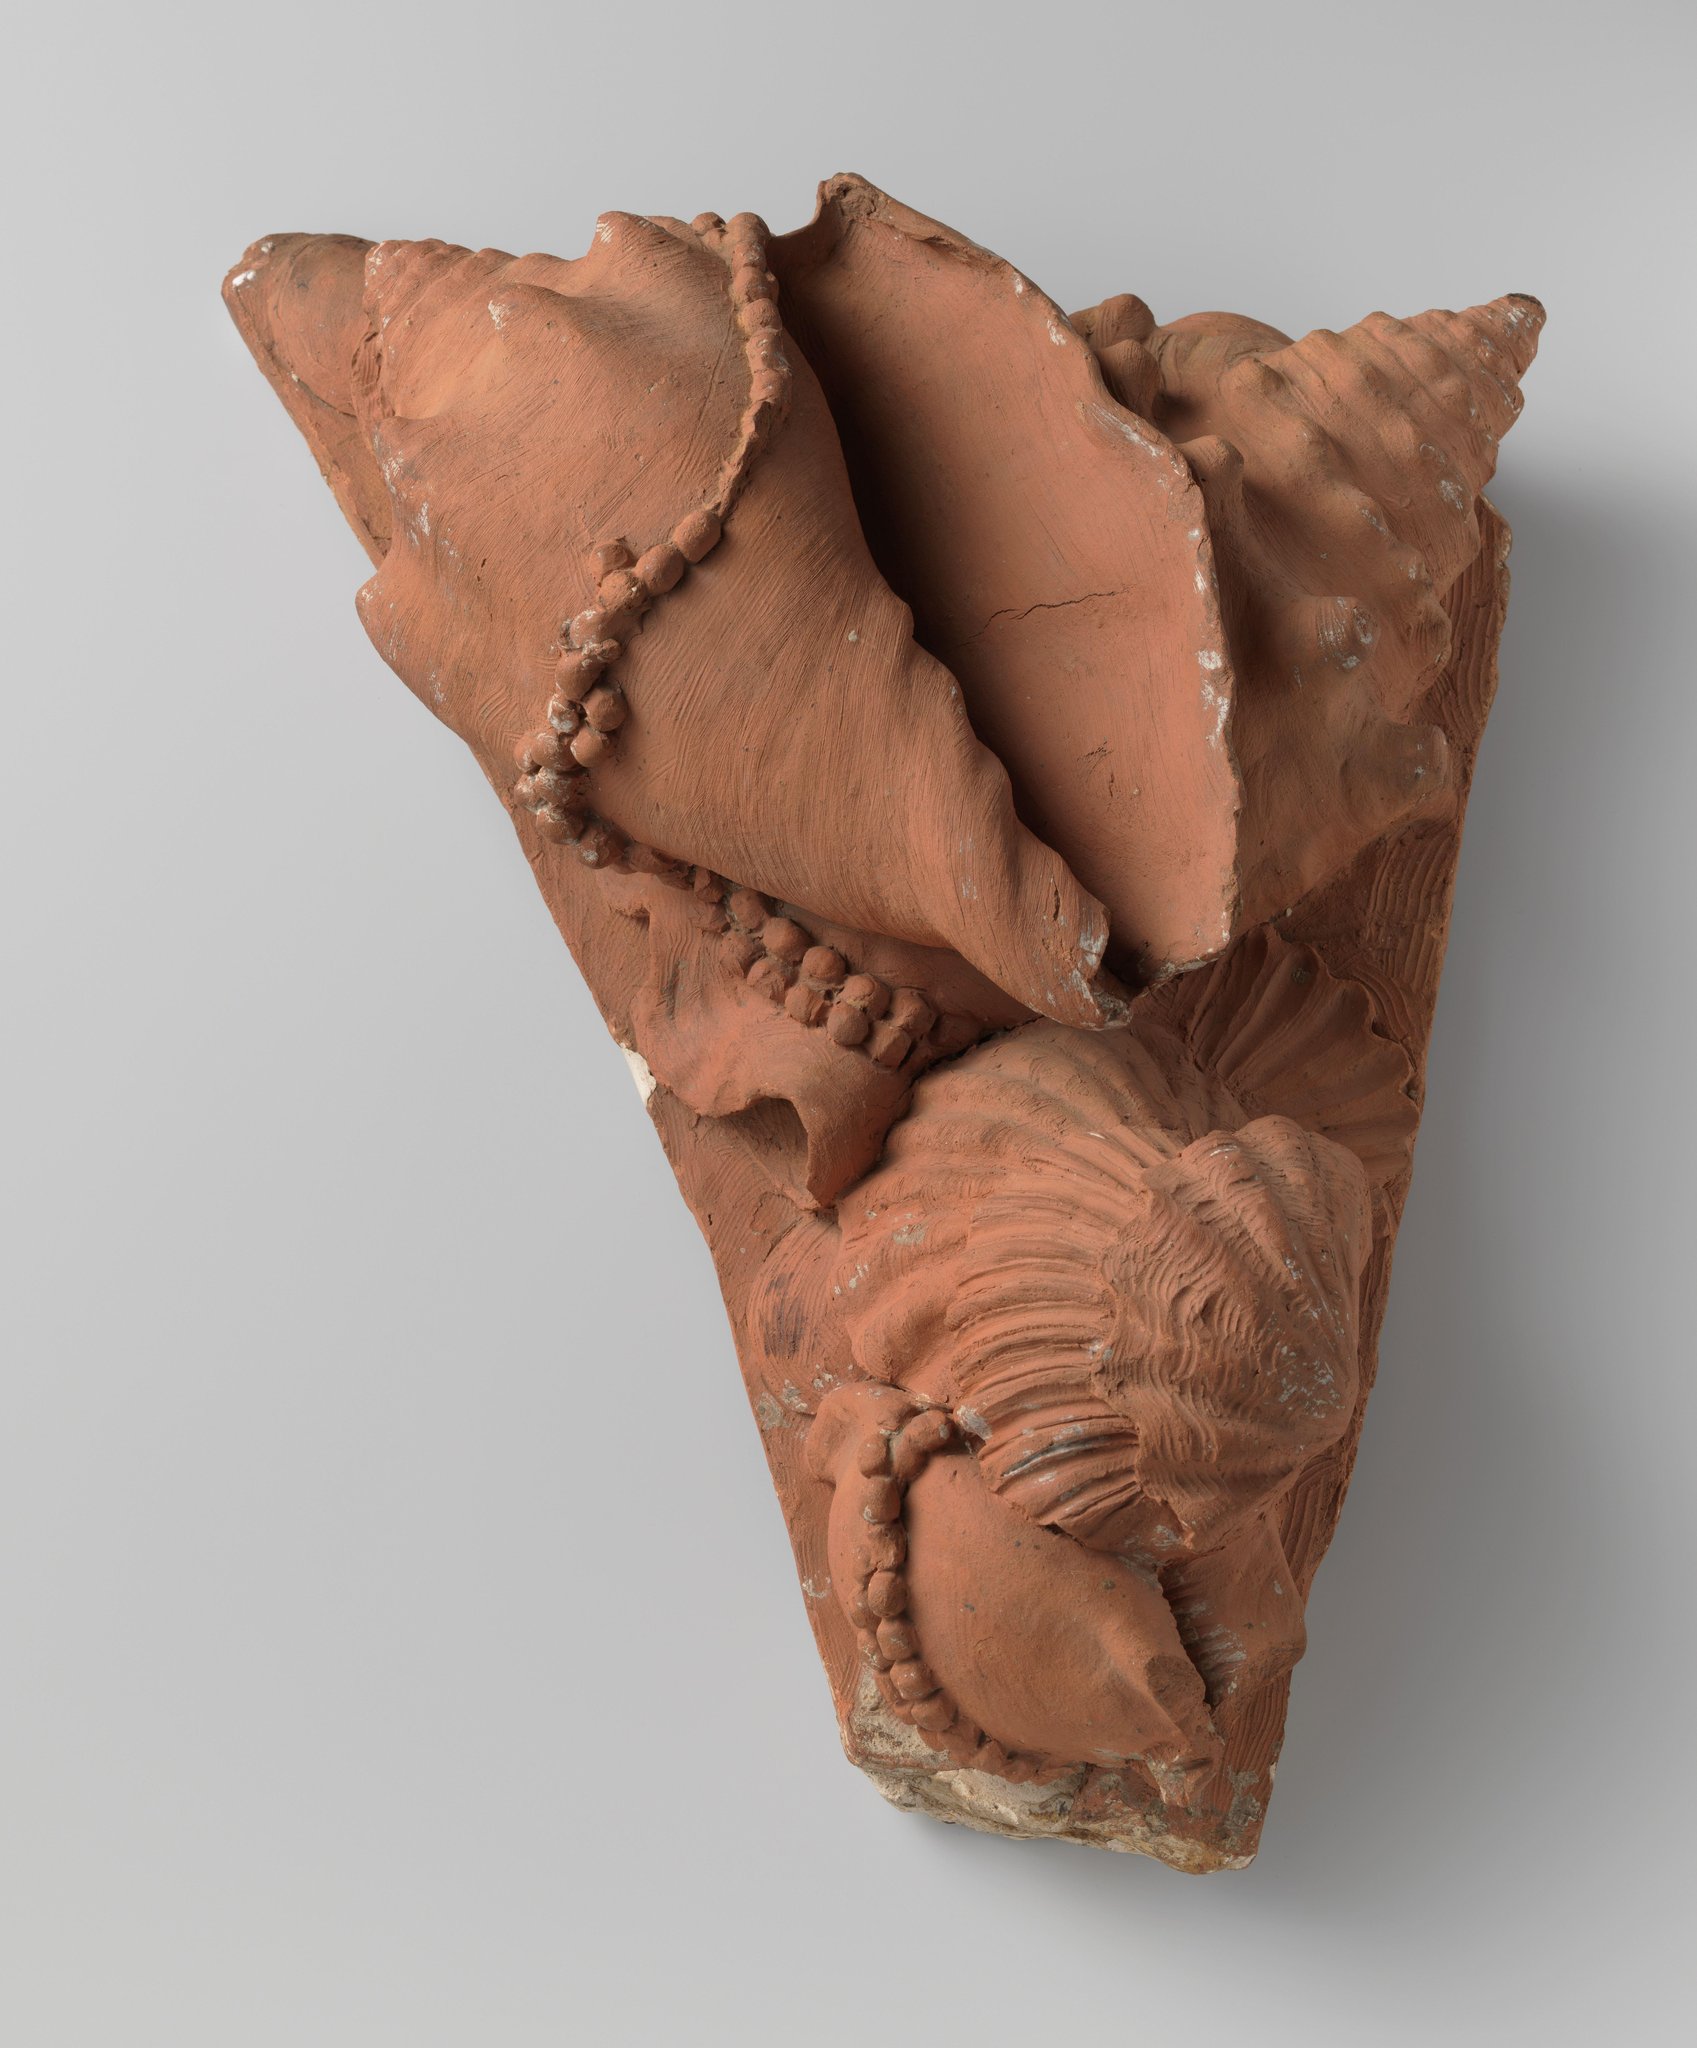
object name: sculpture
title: Model for a Spandrel Ornament with Ten Shells and a String of Pearls, for the Amsterdam Town Hall (now Royal Palace) at Dam Square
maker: artus quellinus (i)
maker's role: draughtsman, print maker, sculptor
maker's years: 1609-1668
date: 1650-1651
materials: terracotta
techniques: modeling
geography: amsterdam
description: De zwikvulling bestaat uit een tiental schelpen. Zij verschillen van vorm, soort en grootte en zijn over elkaar geplaatst; een parelsnoer loopt tussen de schelpen door.